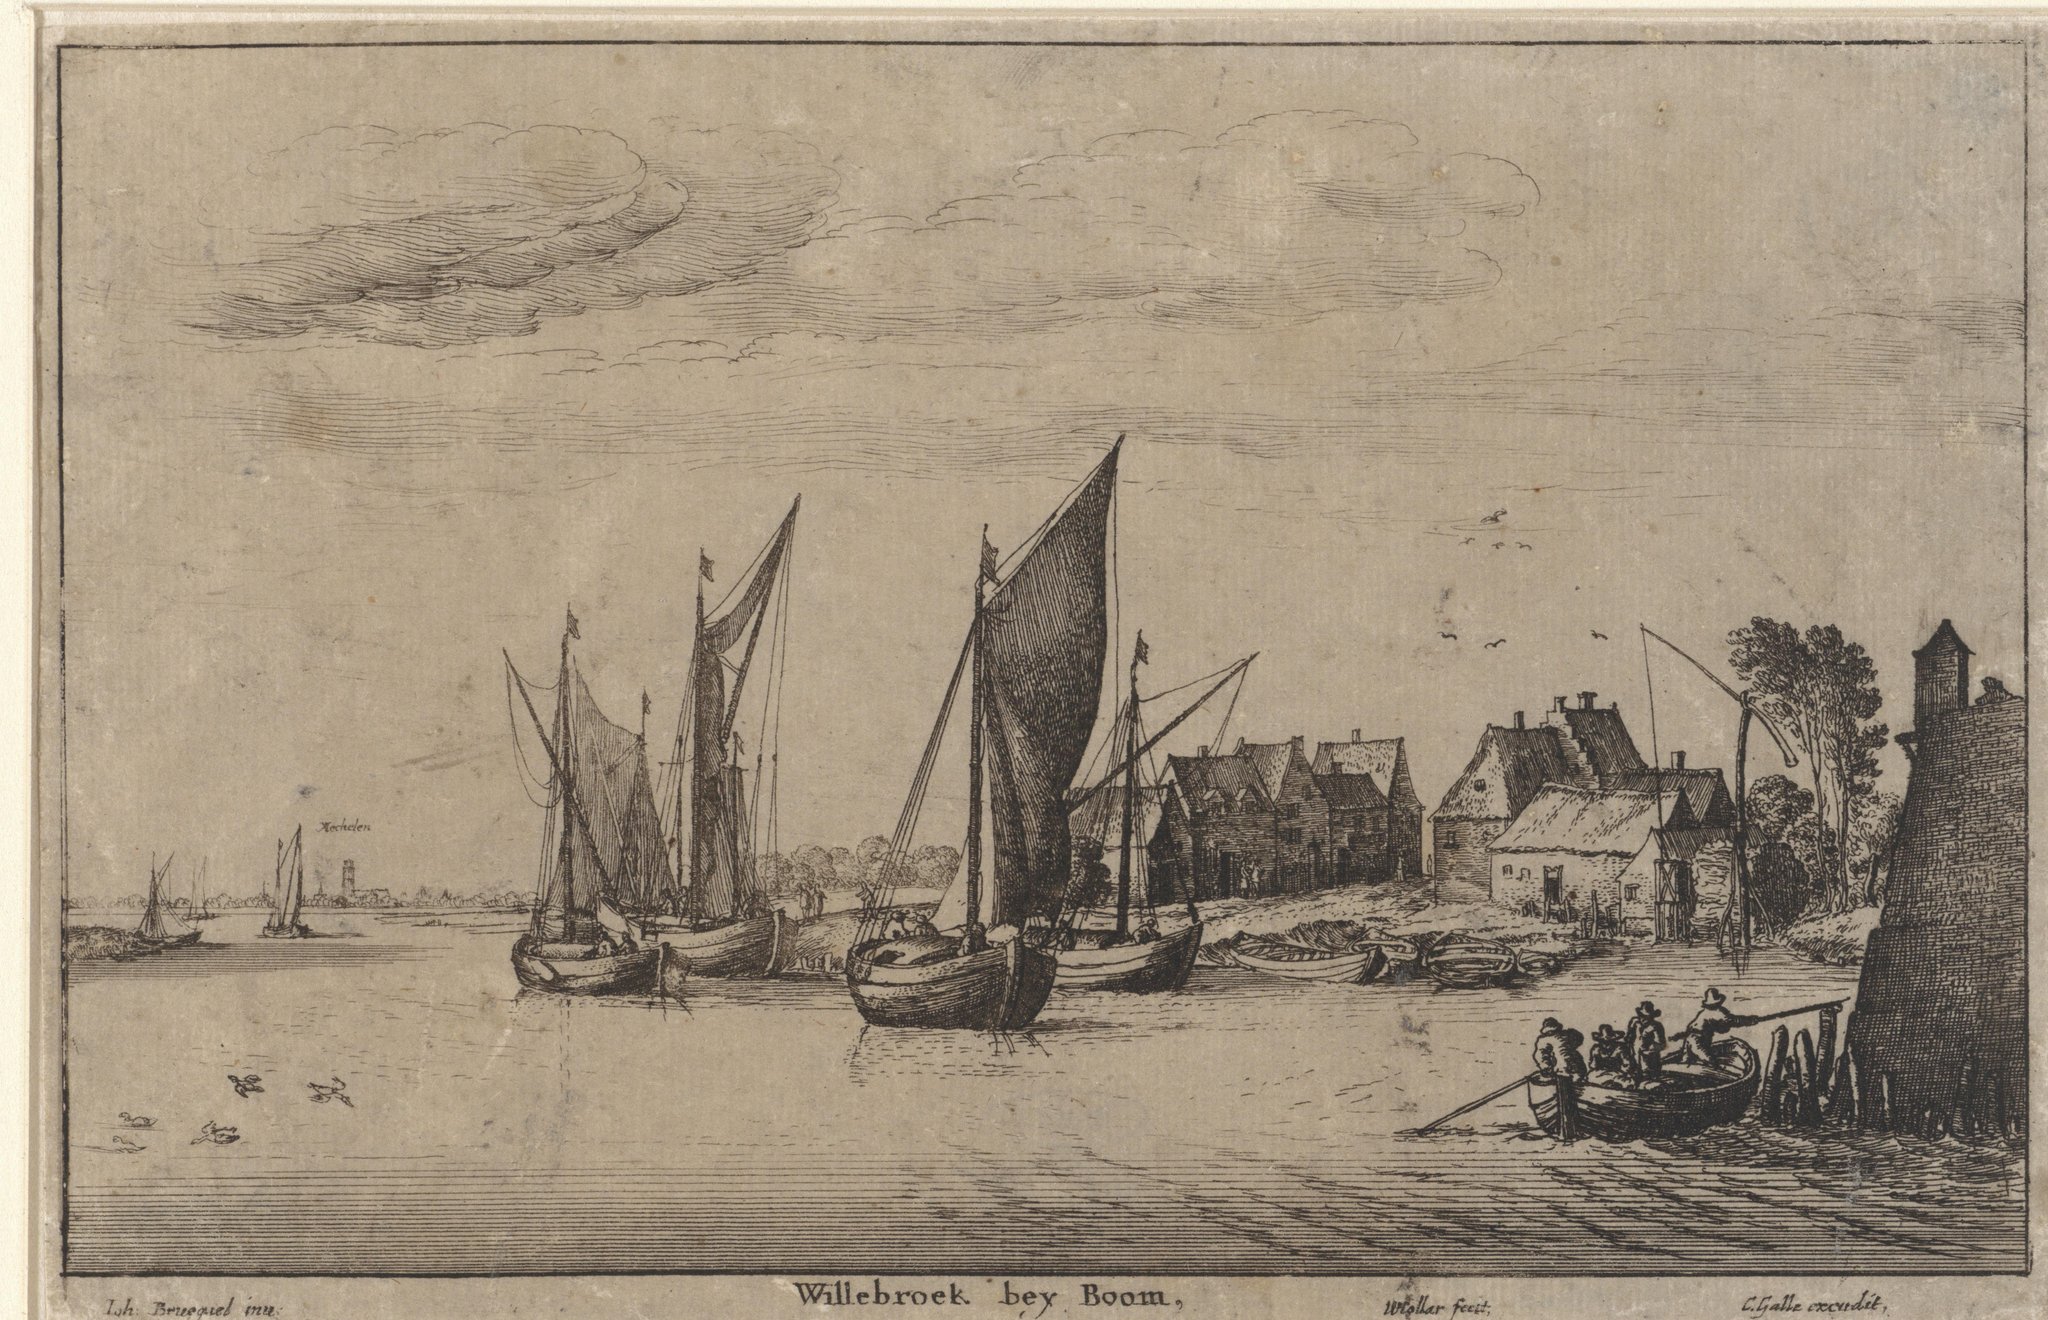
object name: print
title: Willebroek bey Boom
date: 1651-1678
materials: paper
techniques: etching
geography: antwerp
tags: city-view, and landscape with man-made constructions, sailing-ship, sailing-boat, river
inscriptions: collector's mark: Lugt 2228, collector's mark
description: De prent maakt deel uit van een zesdelige serie riviergezichten en kustgezichten, ongenummerd.